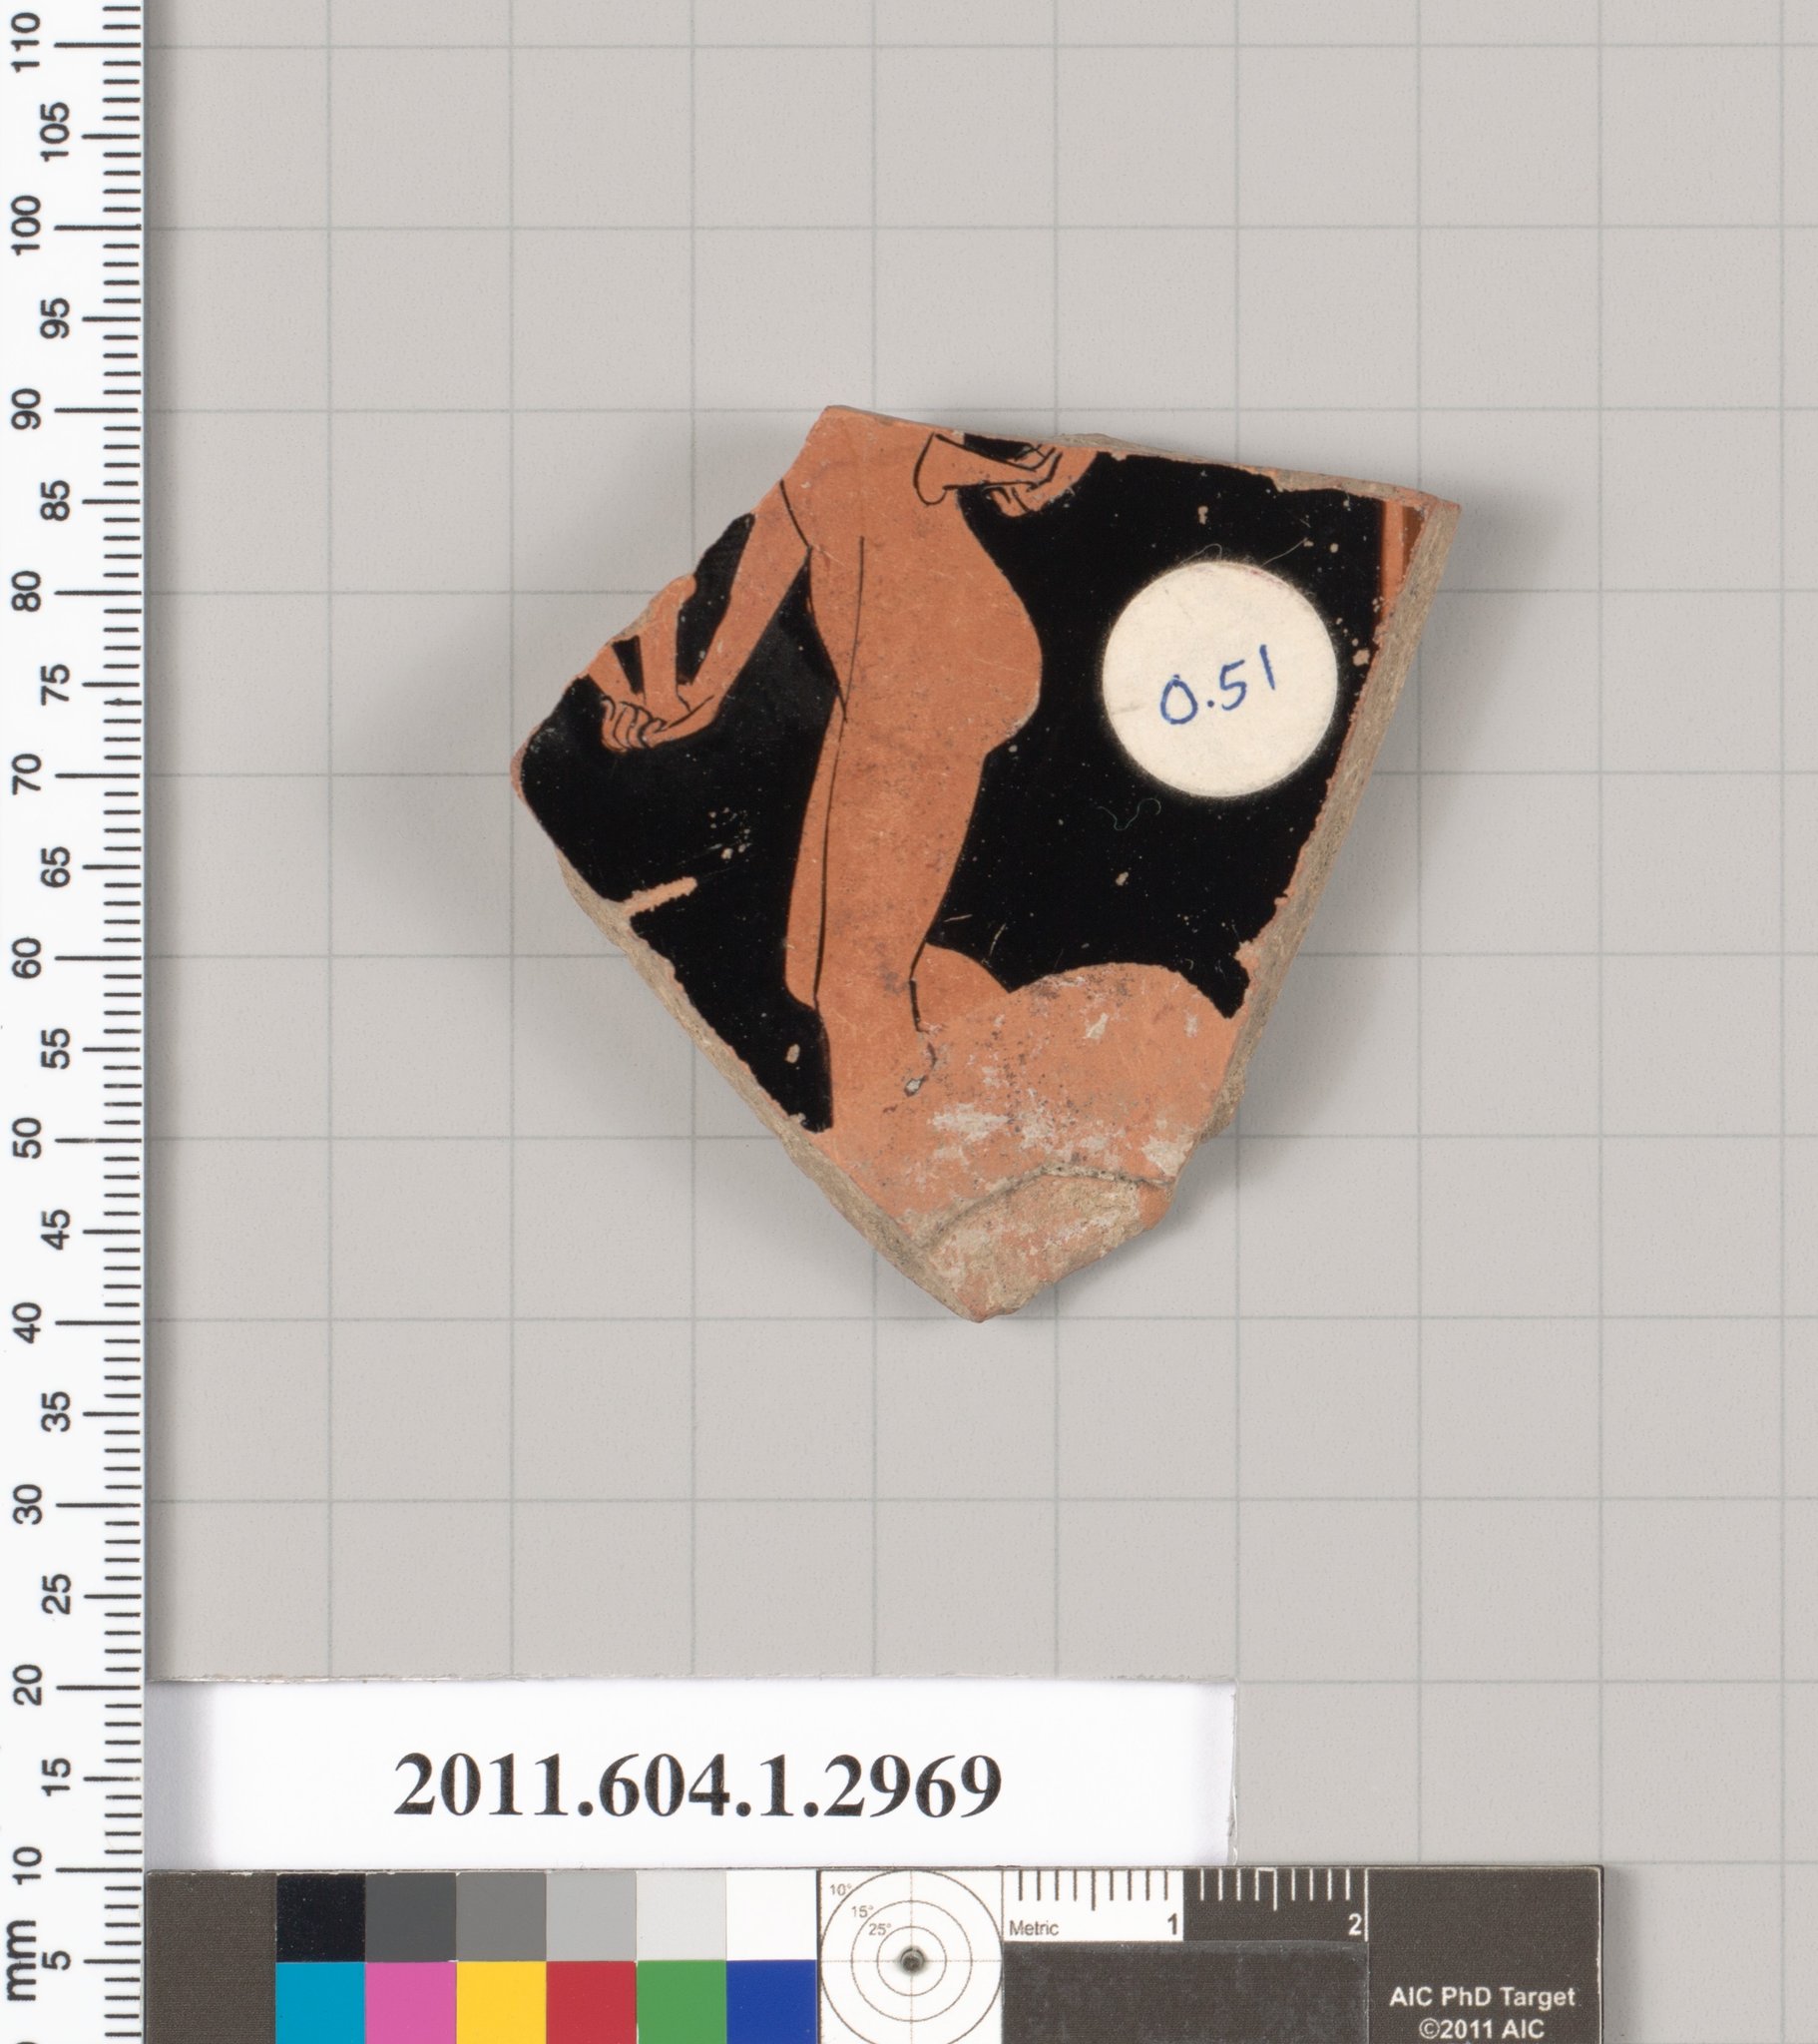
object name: kylix fragment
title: Terracotta fragment of a kylix (drinking cup)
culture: greek, attic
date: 500-480 BCE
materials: terracotta